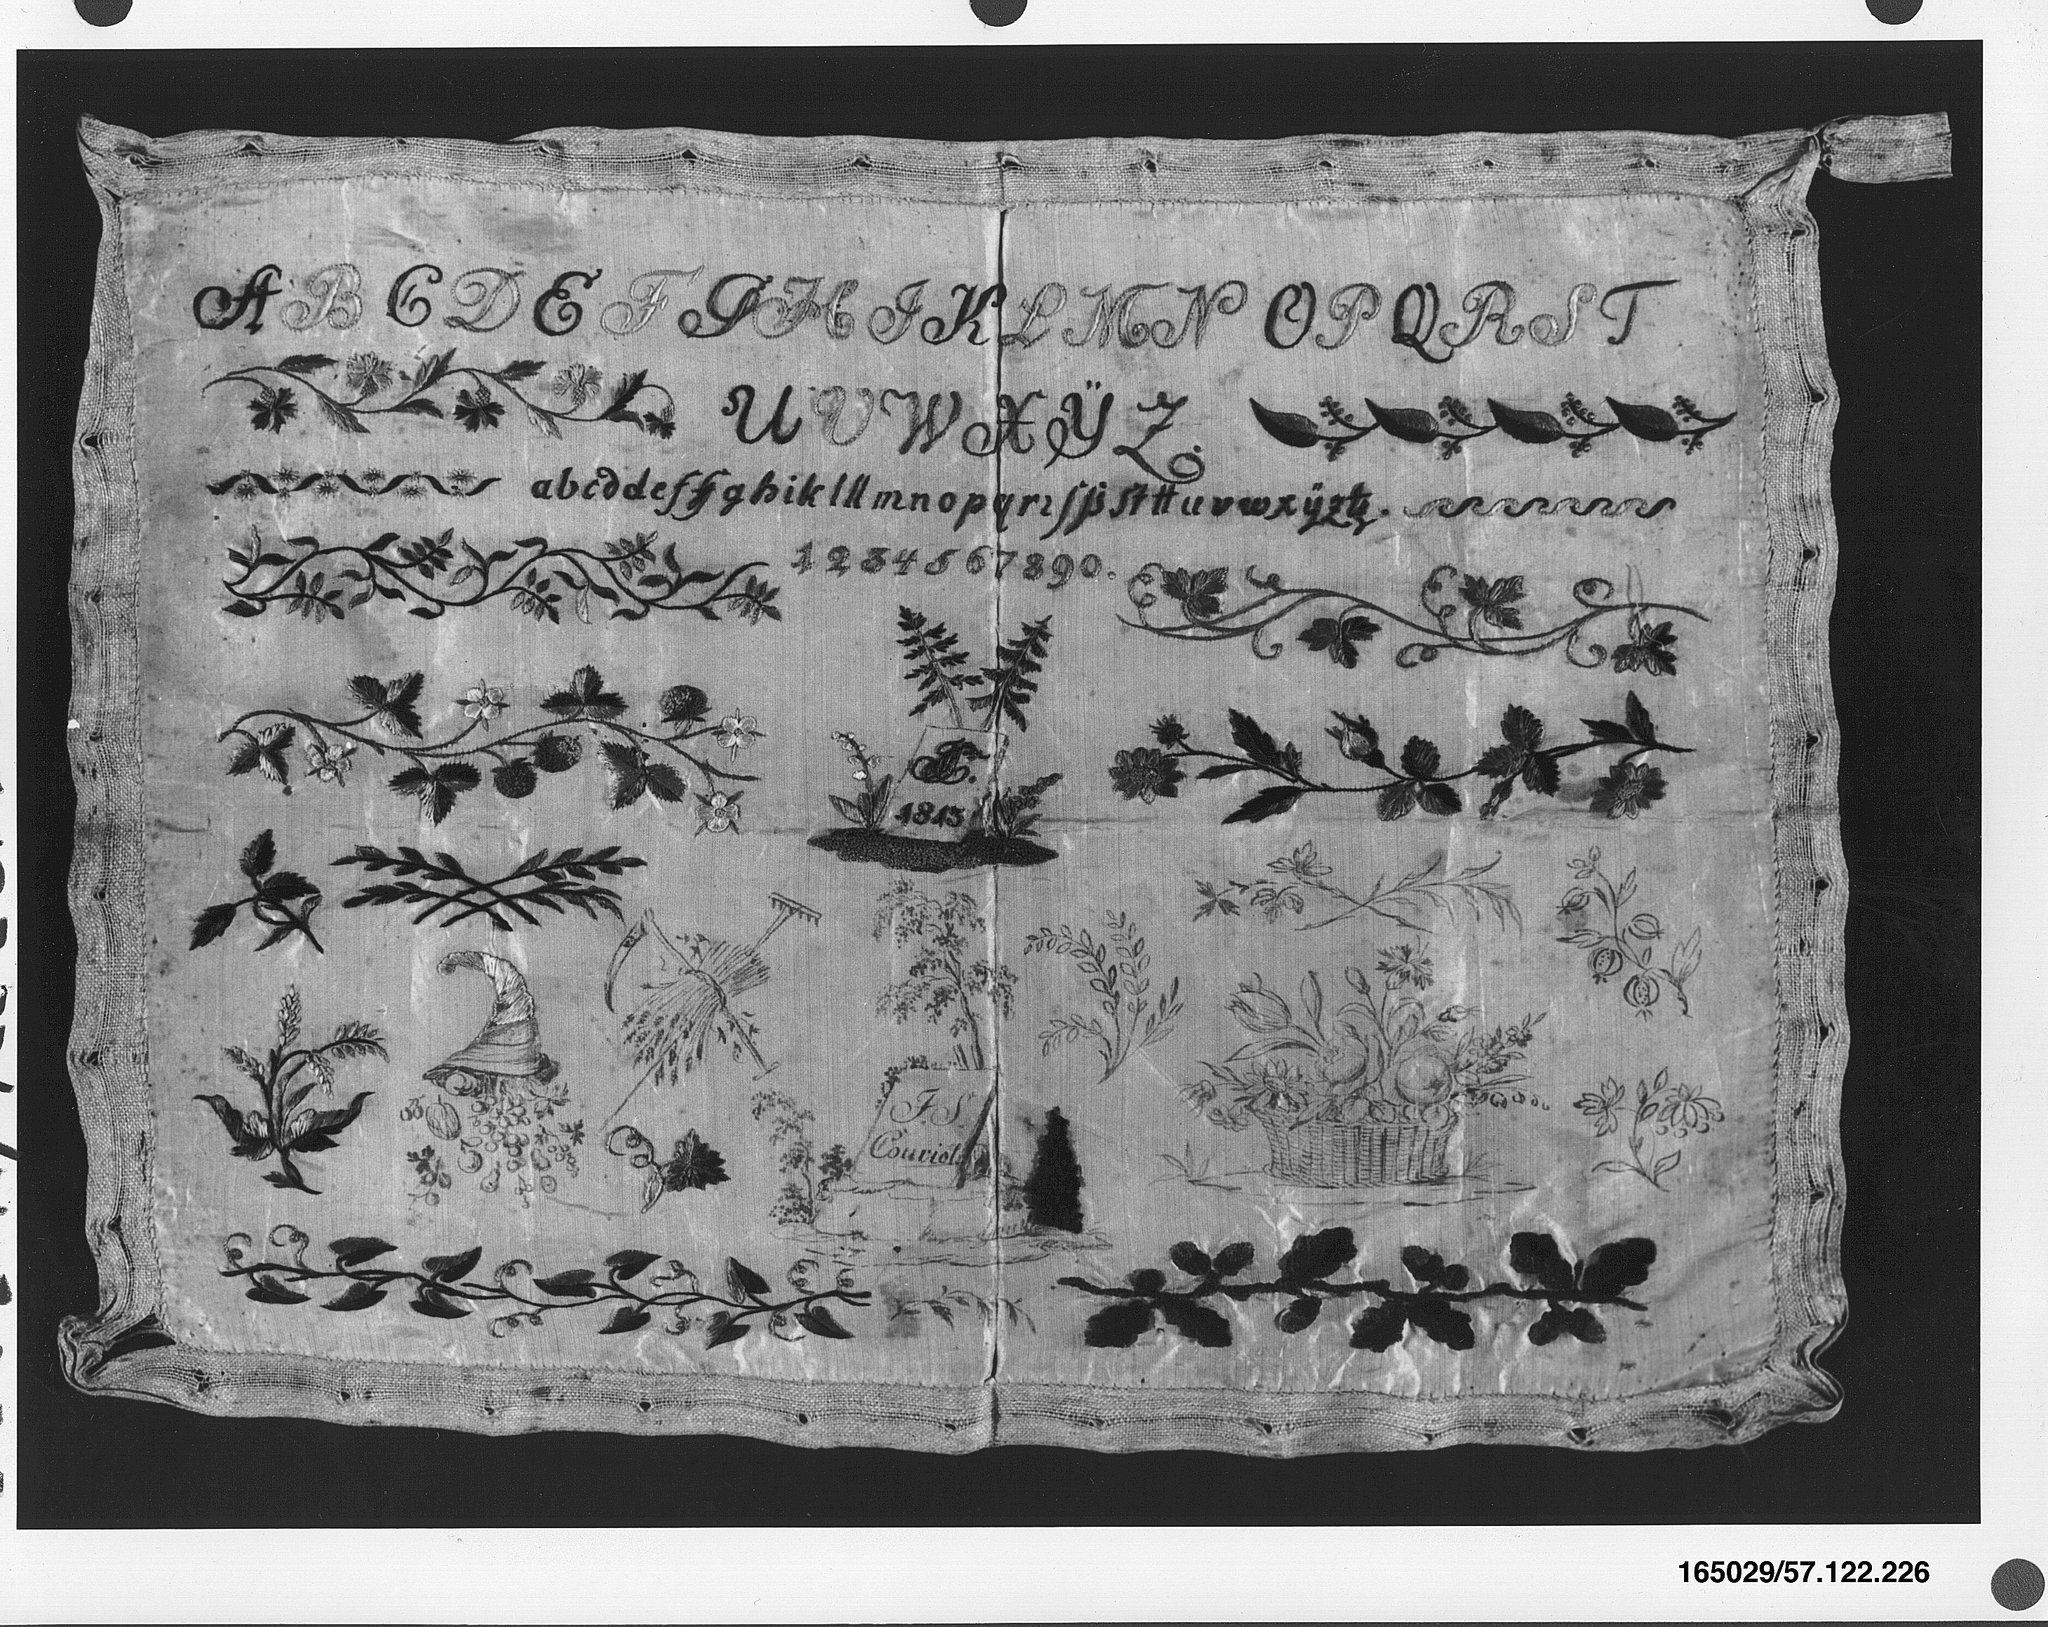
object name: sampler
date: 1813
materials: silk, thread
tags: flowers